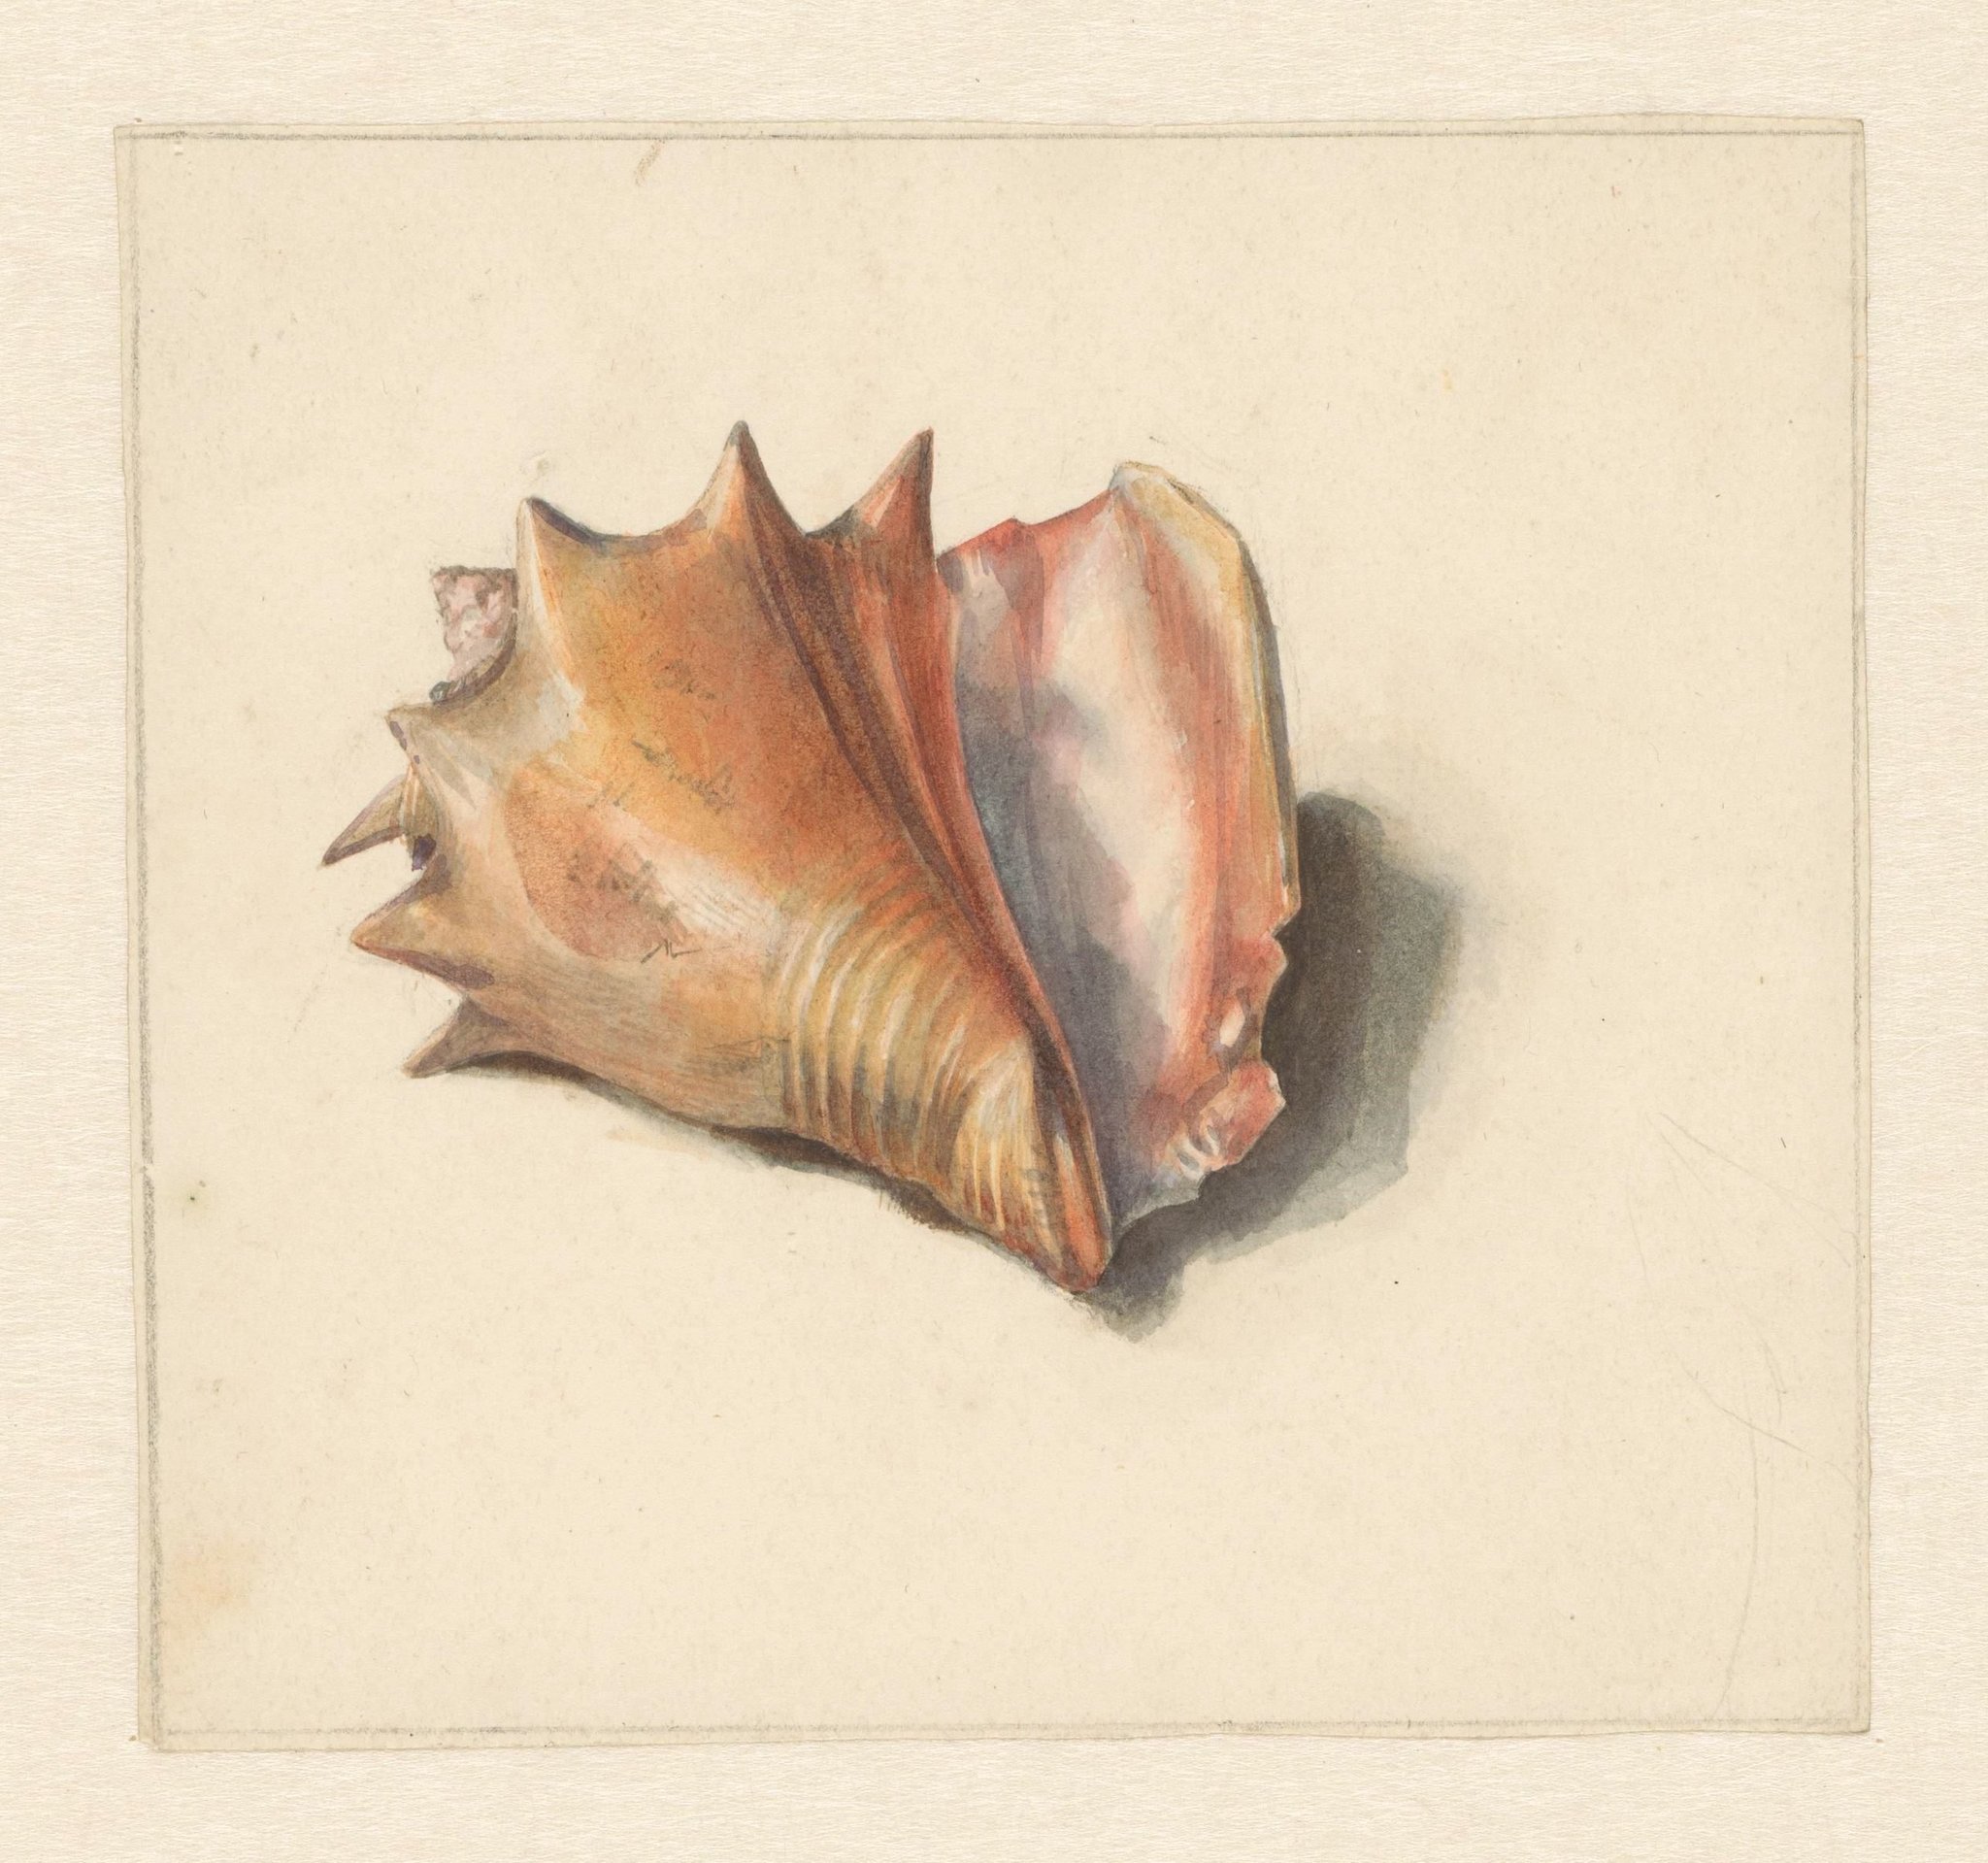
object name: watercolor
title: Studie van een schelp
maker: albertus steenbergen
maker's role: draughtsman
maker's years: 1814-1900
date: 1824-1900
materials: paper, pencil, watercolor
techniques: brush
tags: molluscs (+ shell, snail-shell etc.)